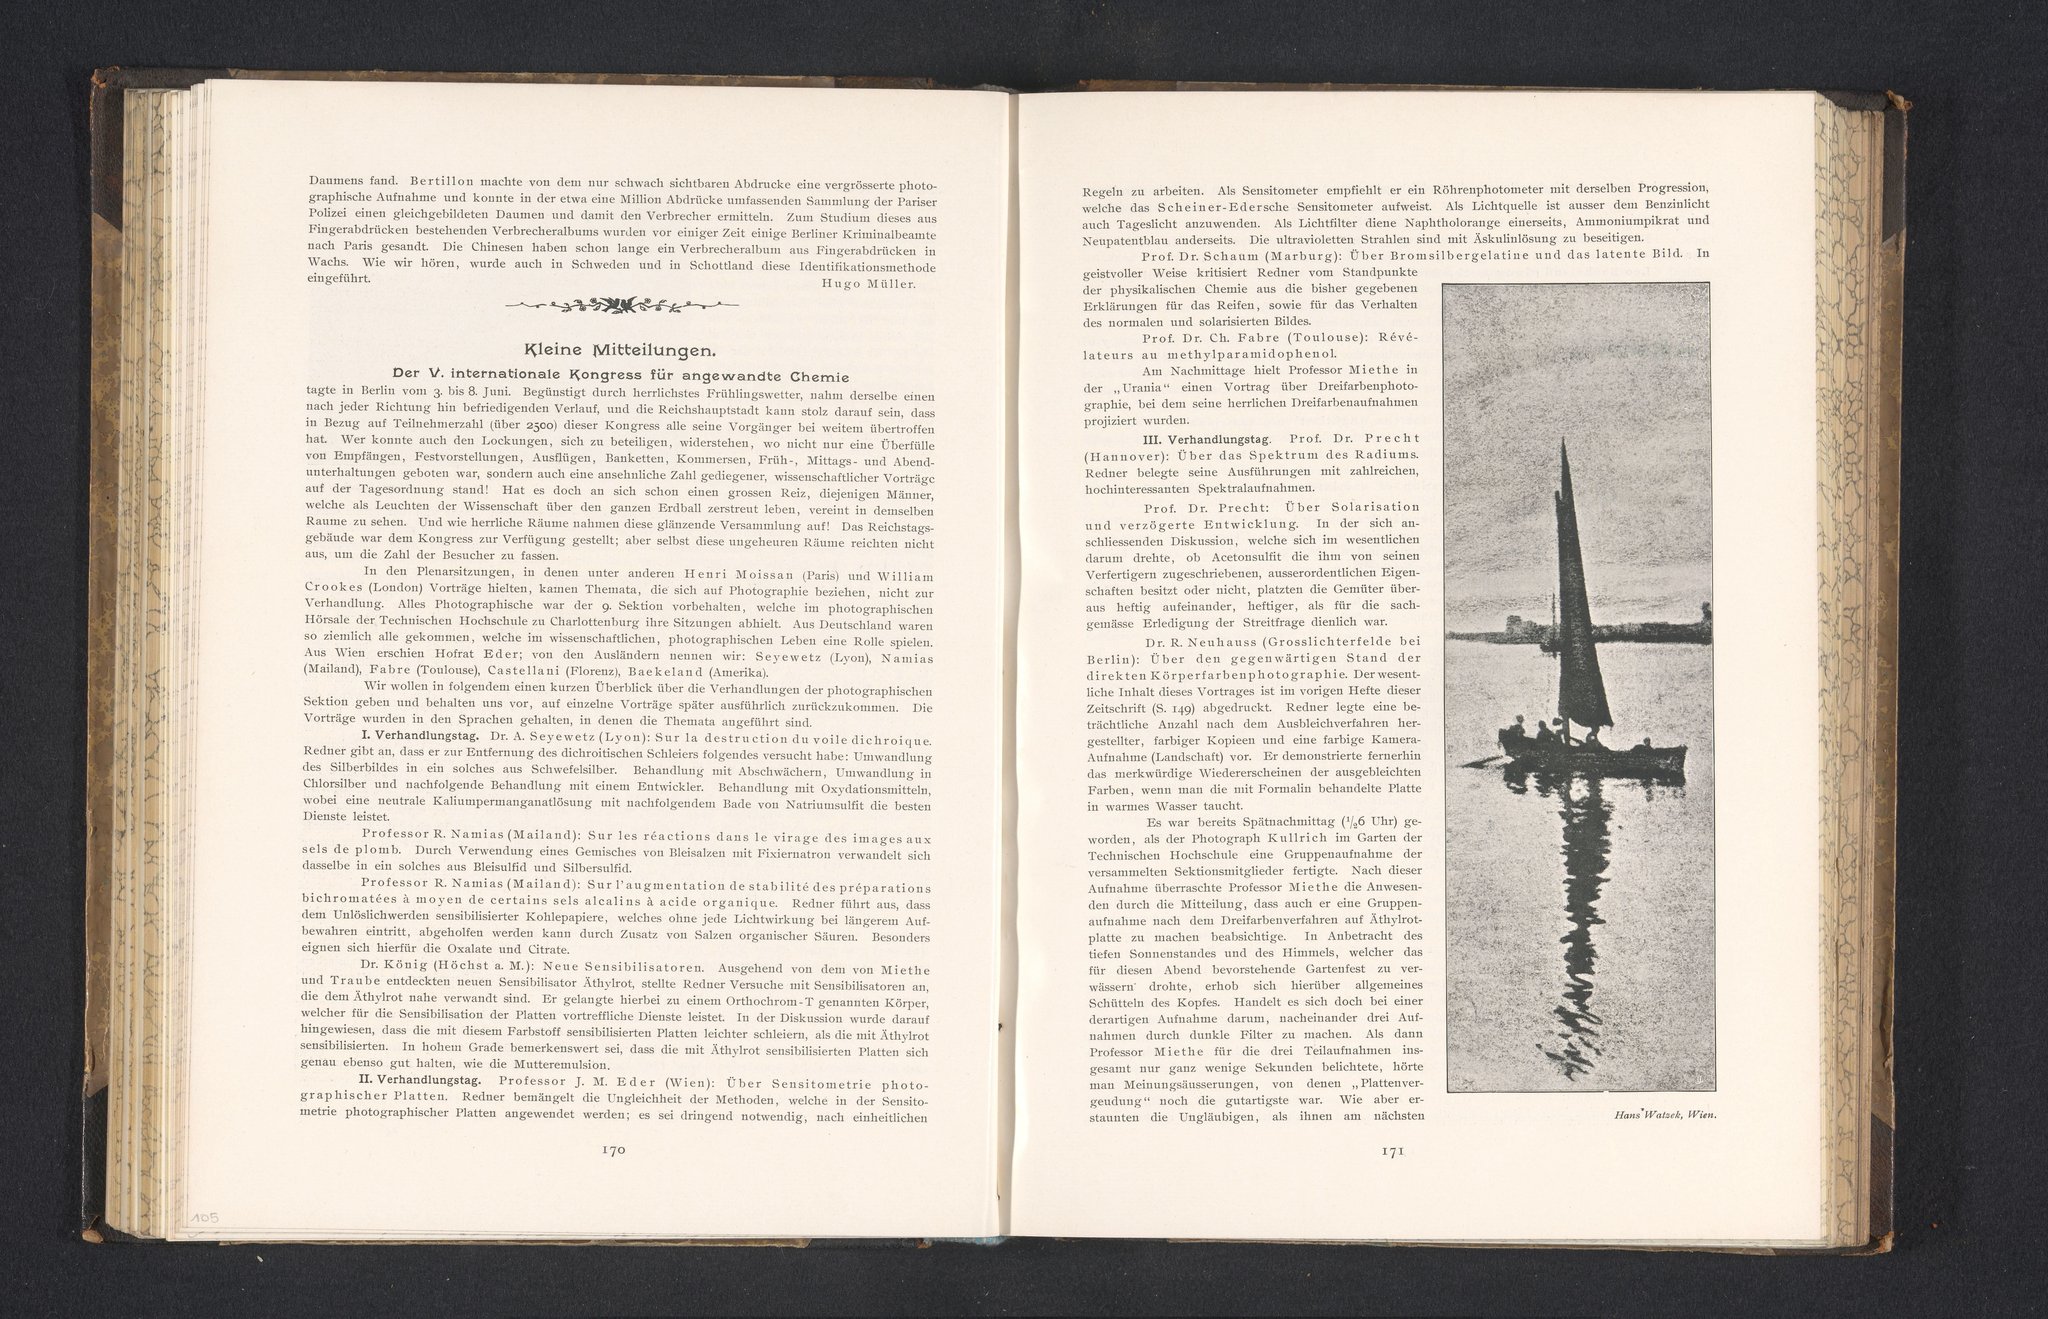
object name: photomechanical print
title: Zeilboot op het water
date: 1898-1903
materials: paper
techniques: autotype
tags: sailing-ship, sailing-boat, river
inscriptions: monogram: ‘JL’